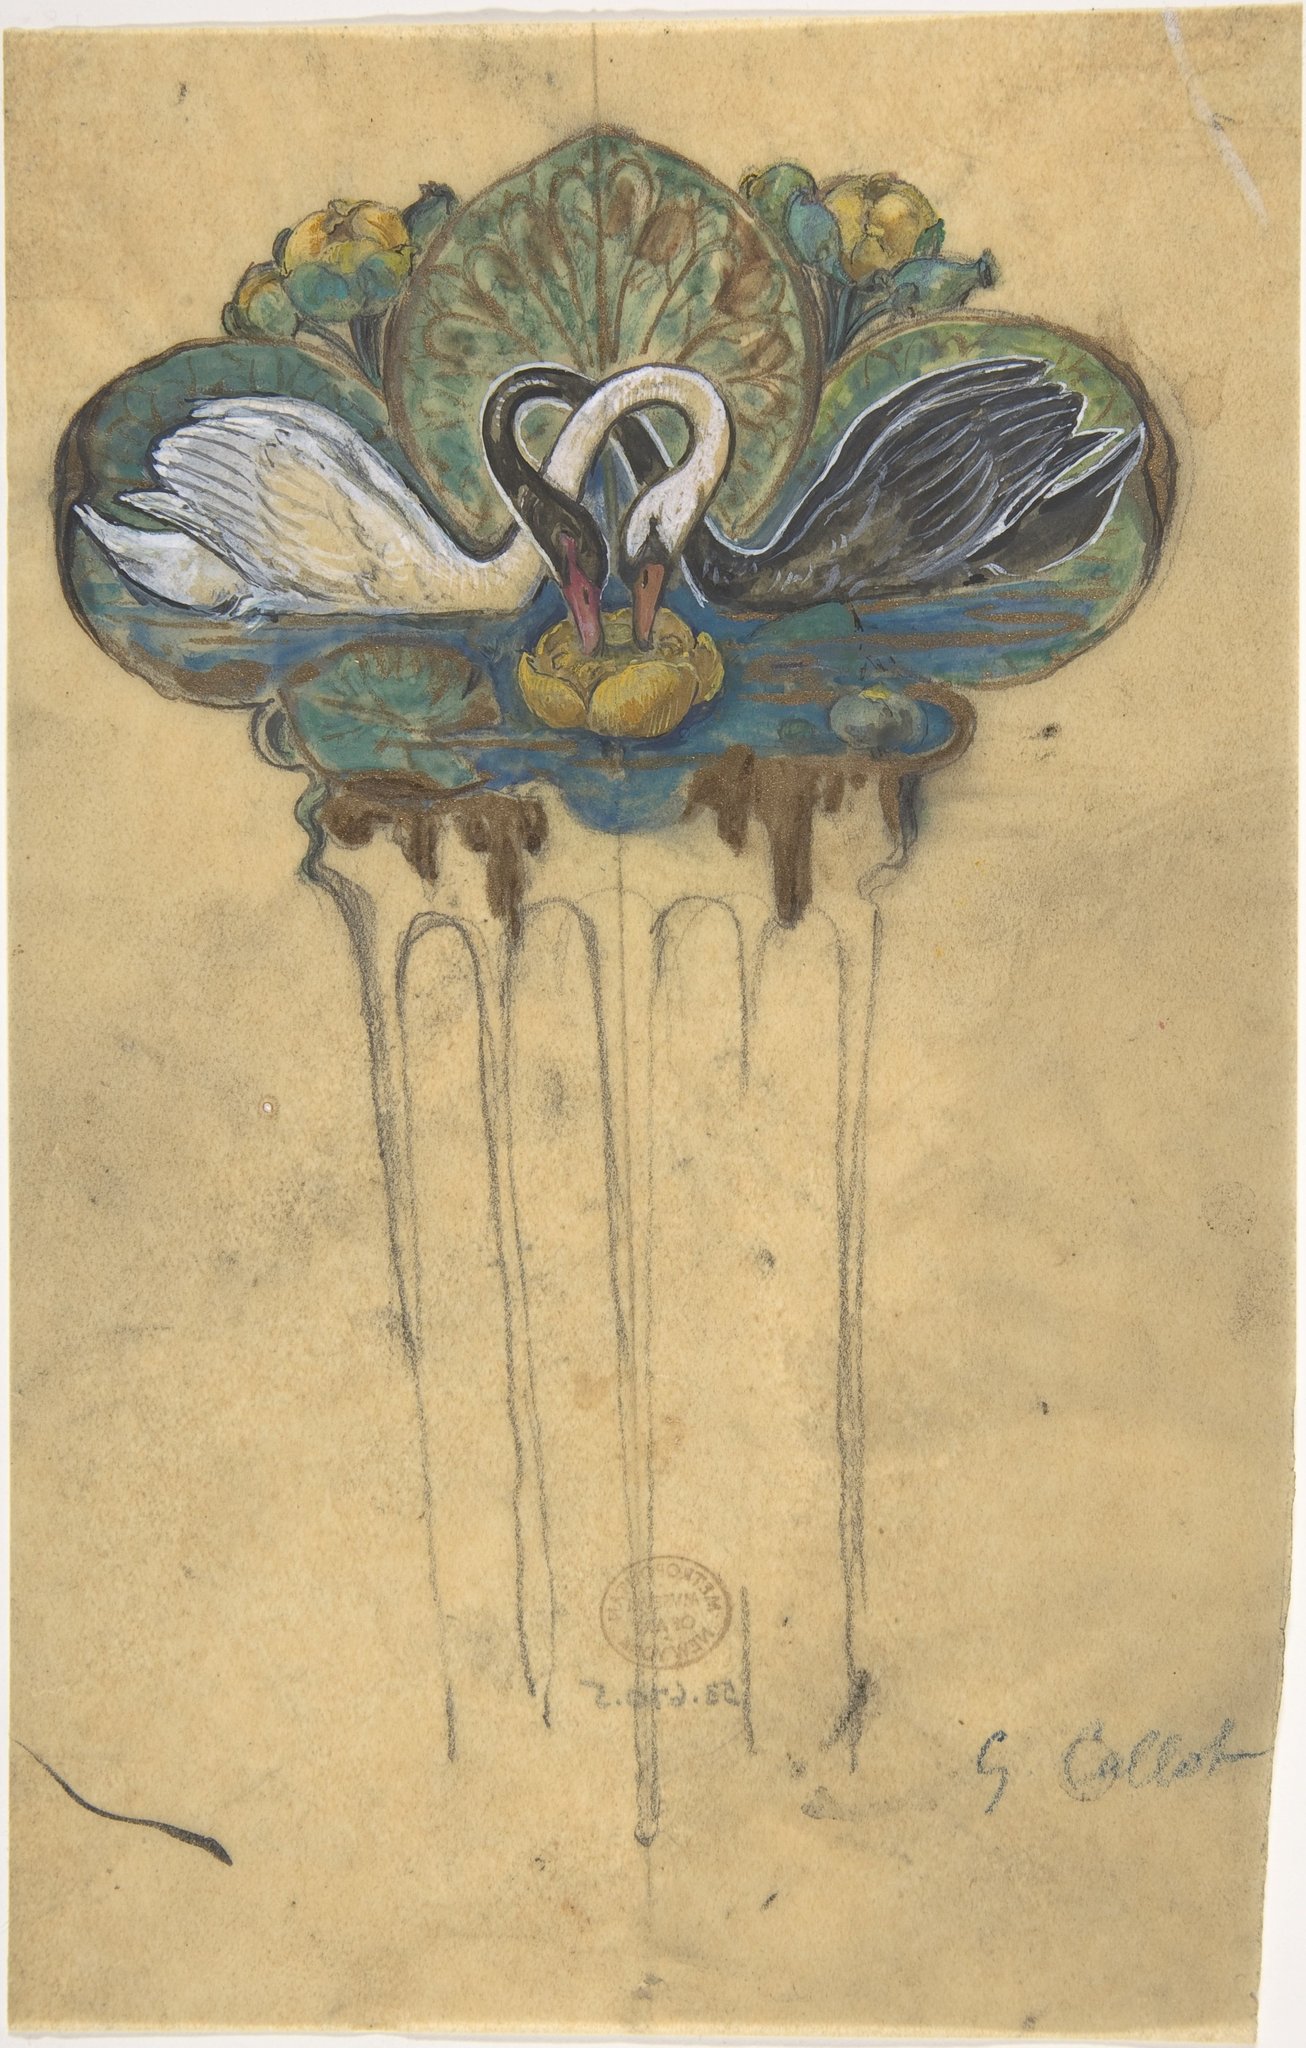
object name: album print ornament architecture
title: Design for a Haircomb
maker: jacques caillot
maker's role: artist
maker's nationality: french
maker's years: 1823-1905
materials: gouache, graphite, ink, paint, watercolor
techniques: pen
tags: swans